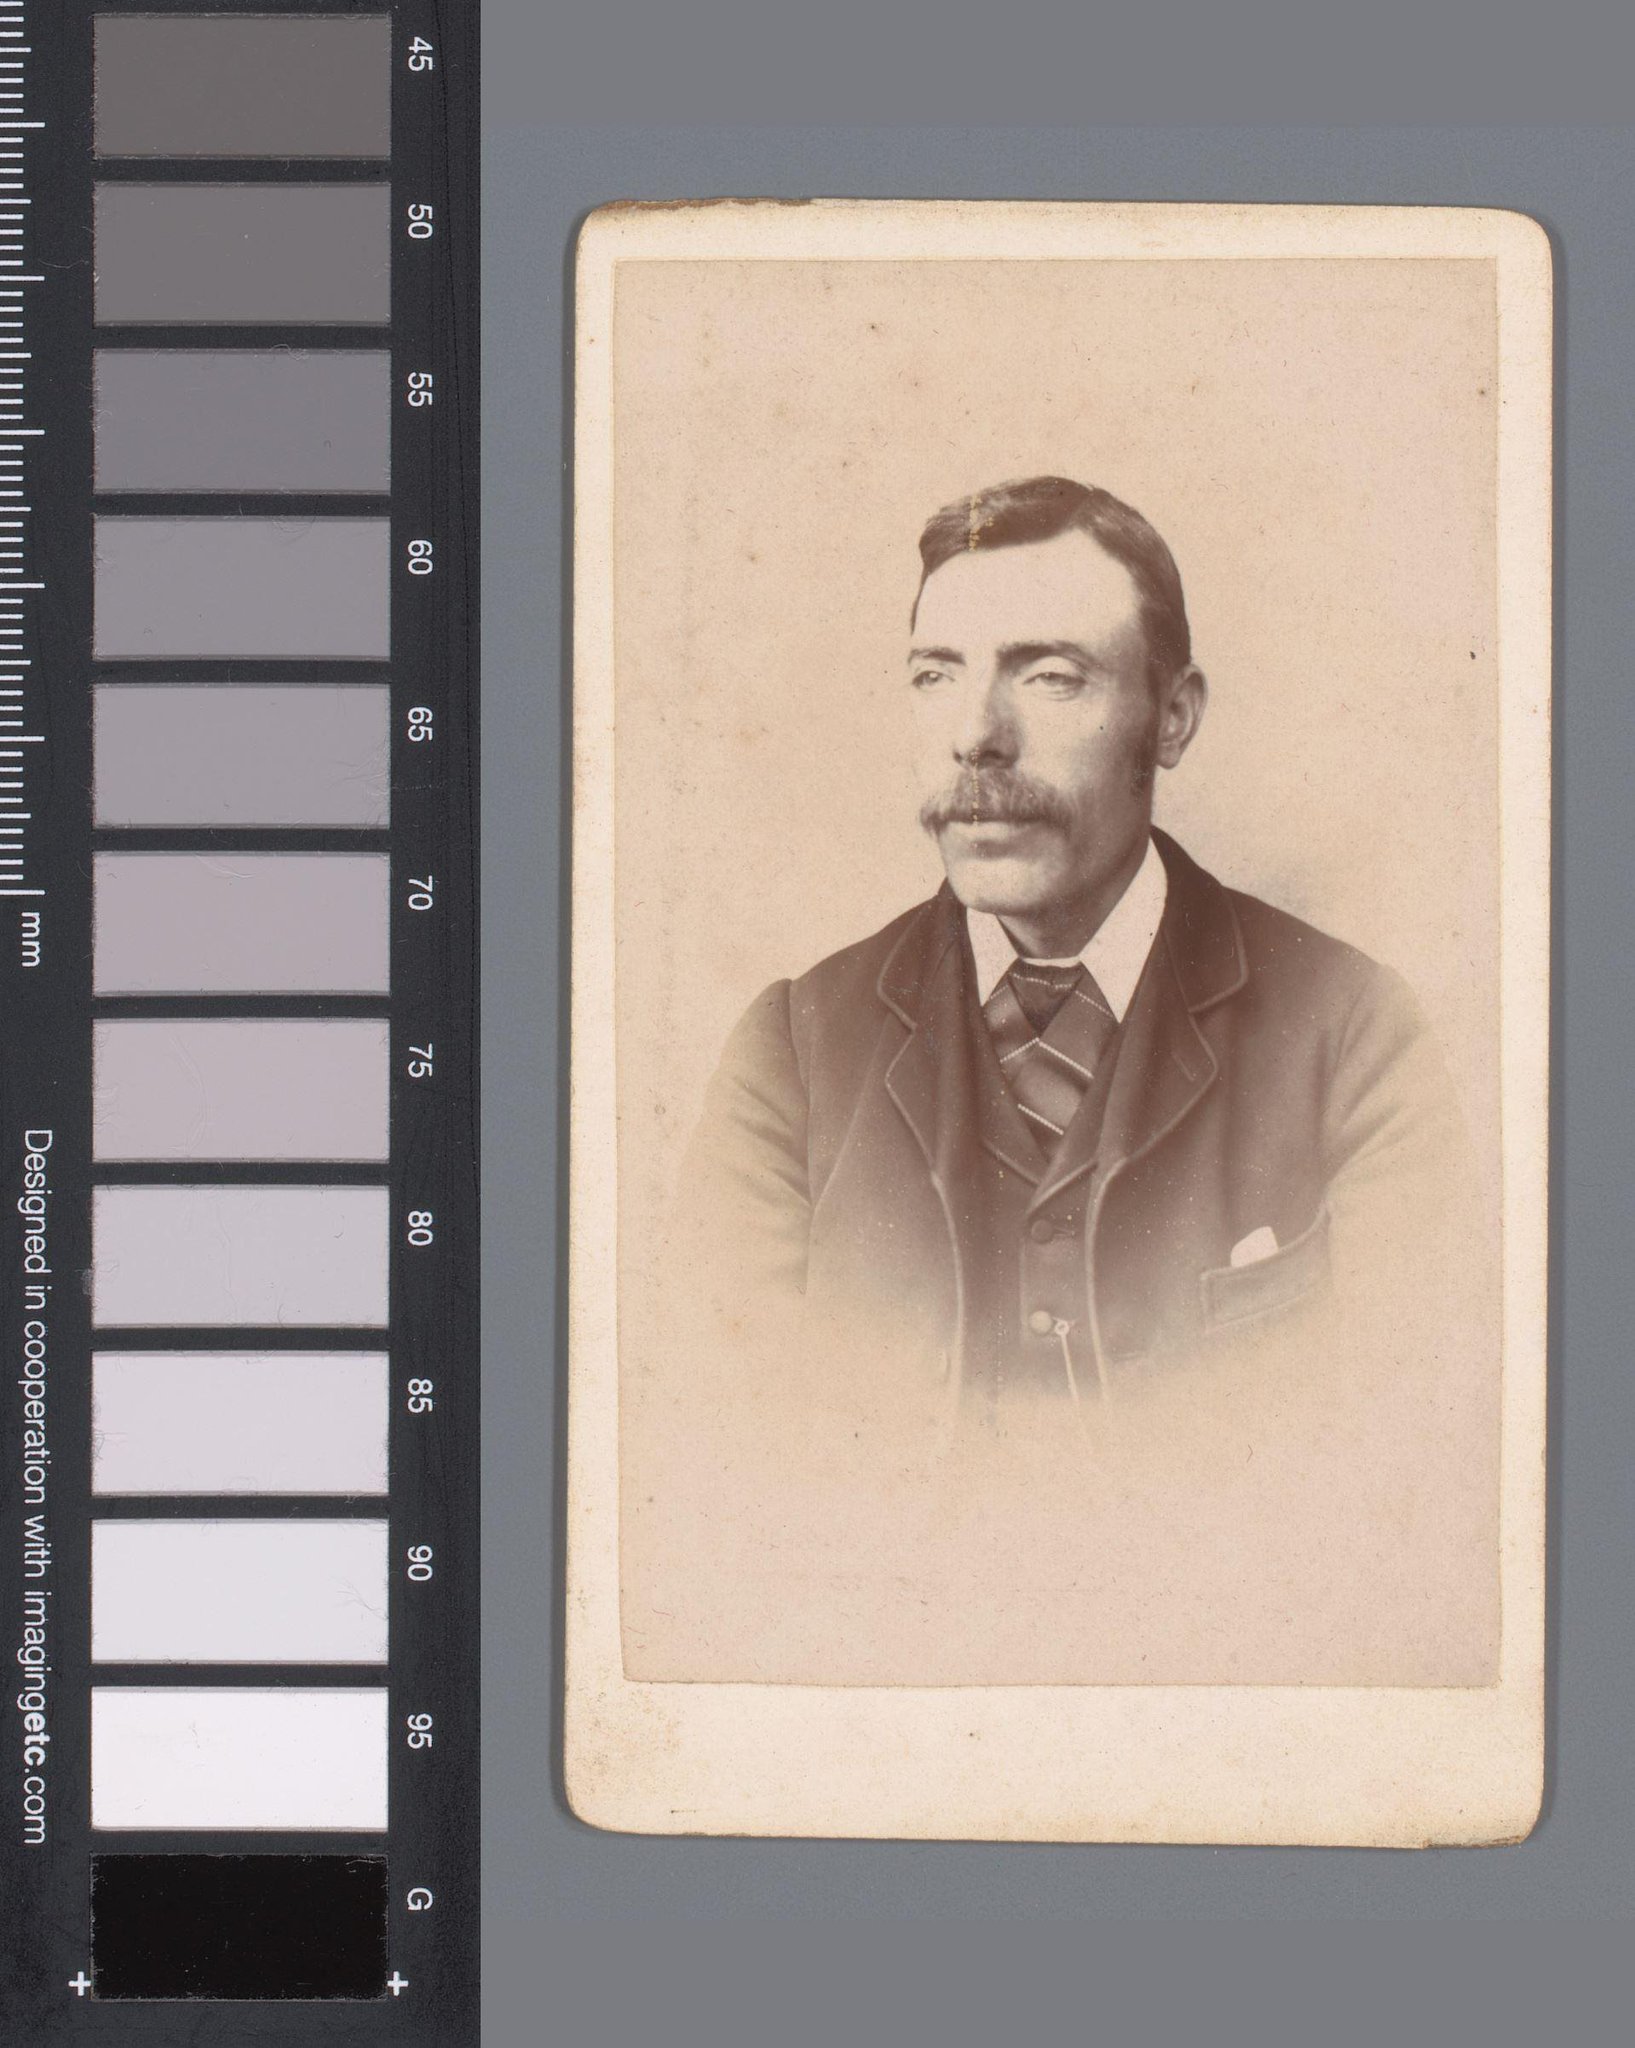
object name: carte de visite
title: Portret van een onbekende man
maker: Anonymous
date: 1900-1914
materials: paper, cardboard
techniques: gelatin silver print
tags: adult man, anonymous historical person portrayed